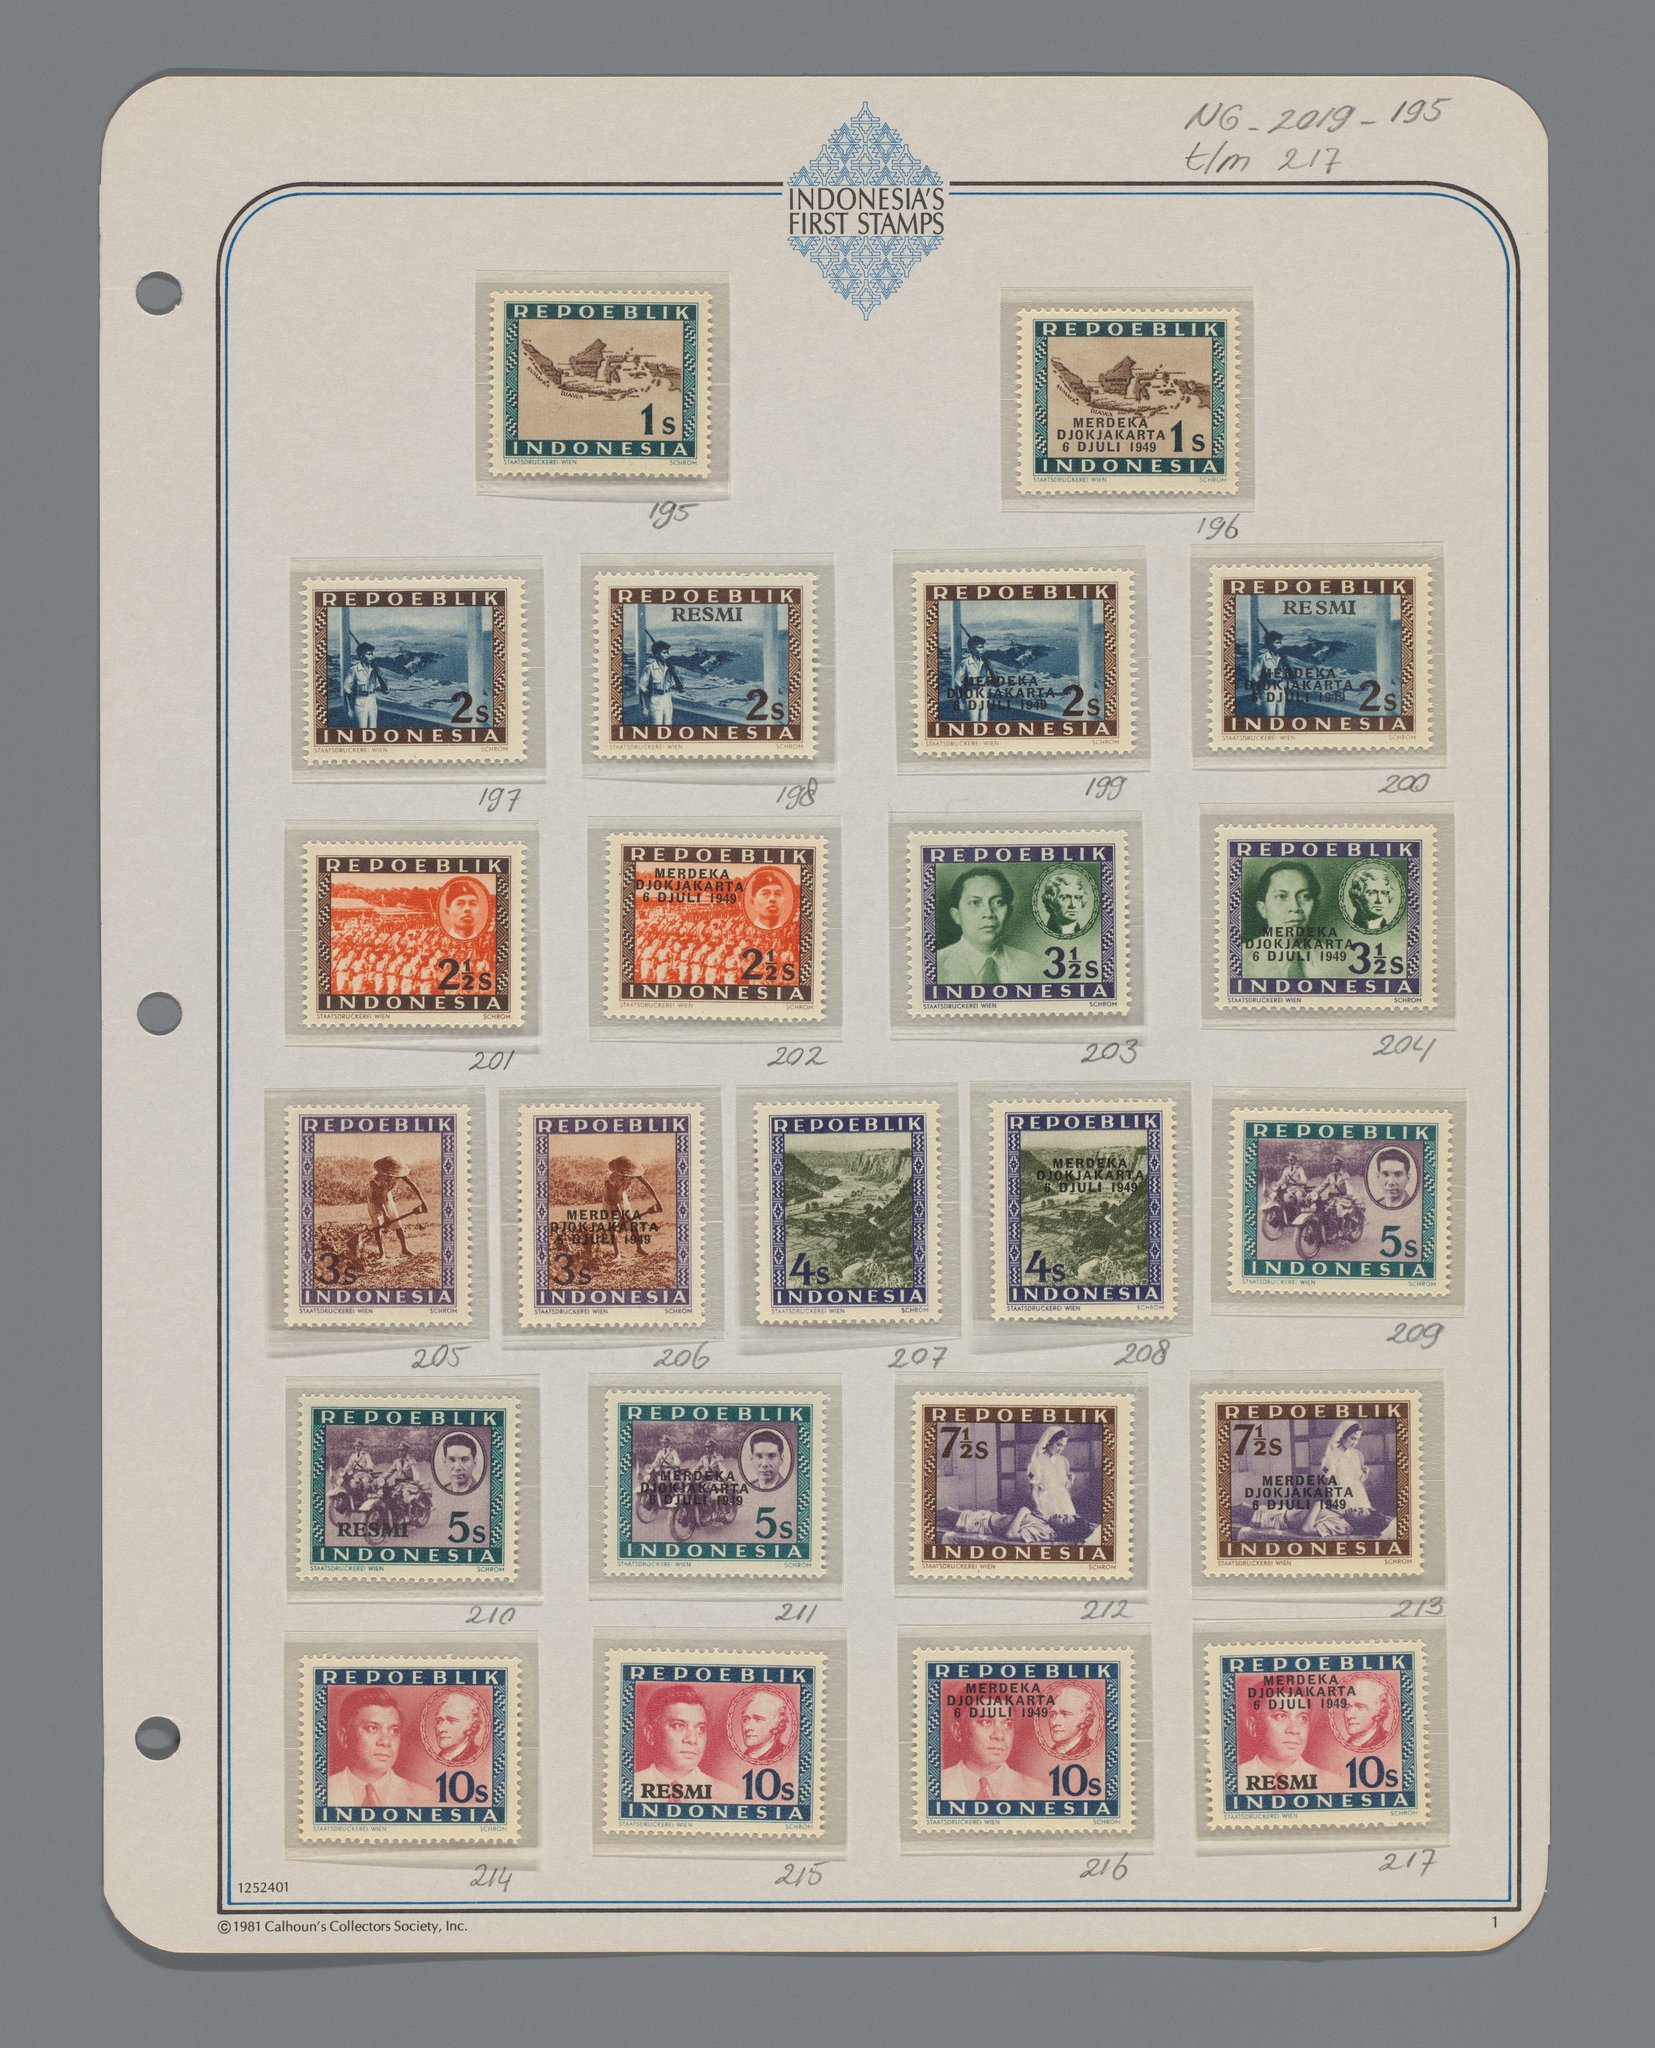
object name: postage stamp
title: Postzegel Republik Indonesia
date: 1949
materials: paper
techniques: photoaquatint, engraving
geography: philadelphia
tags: indonesia